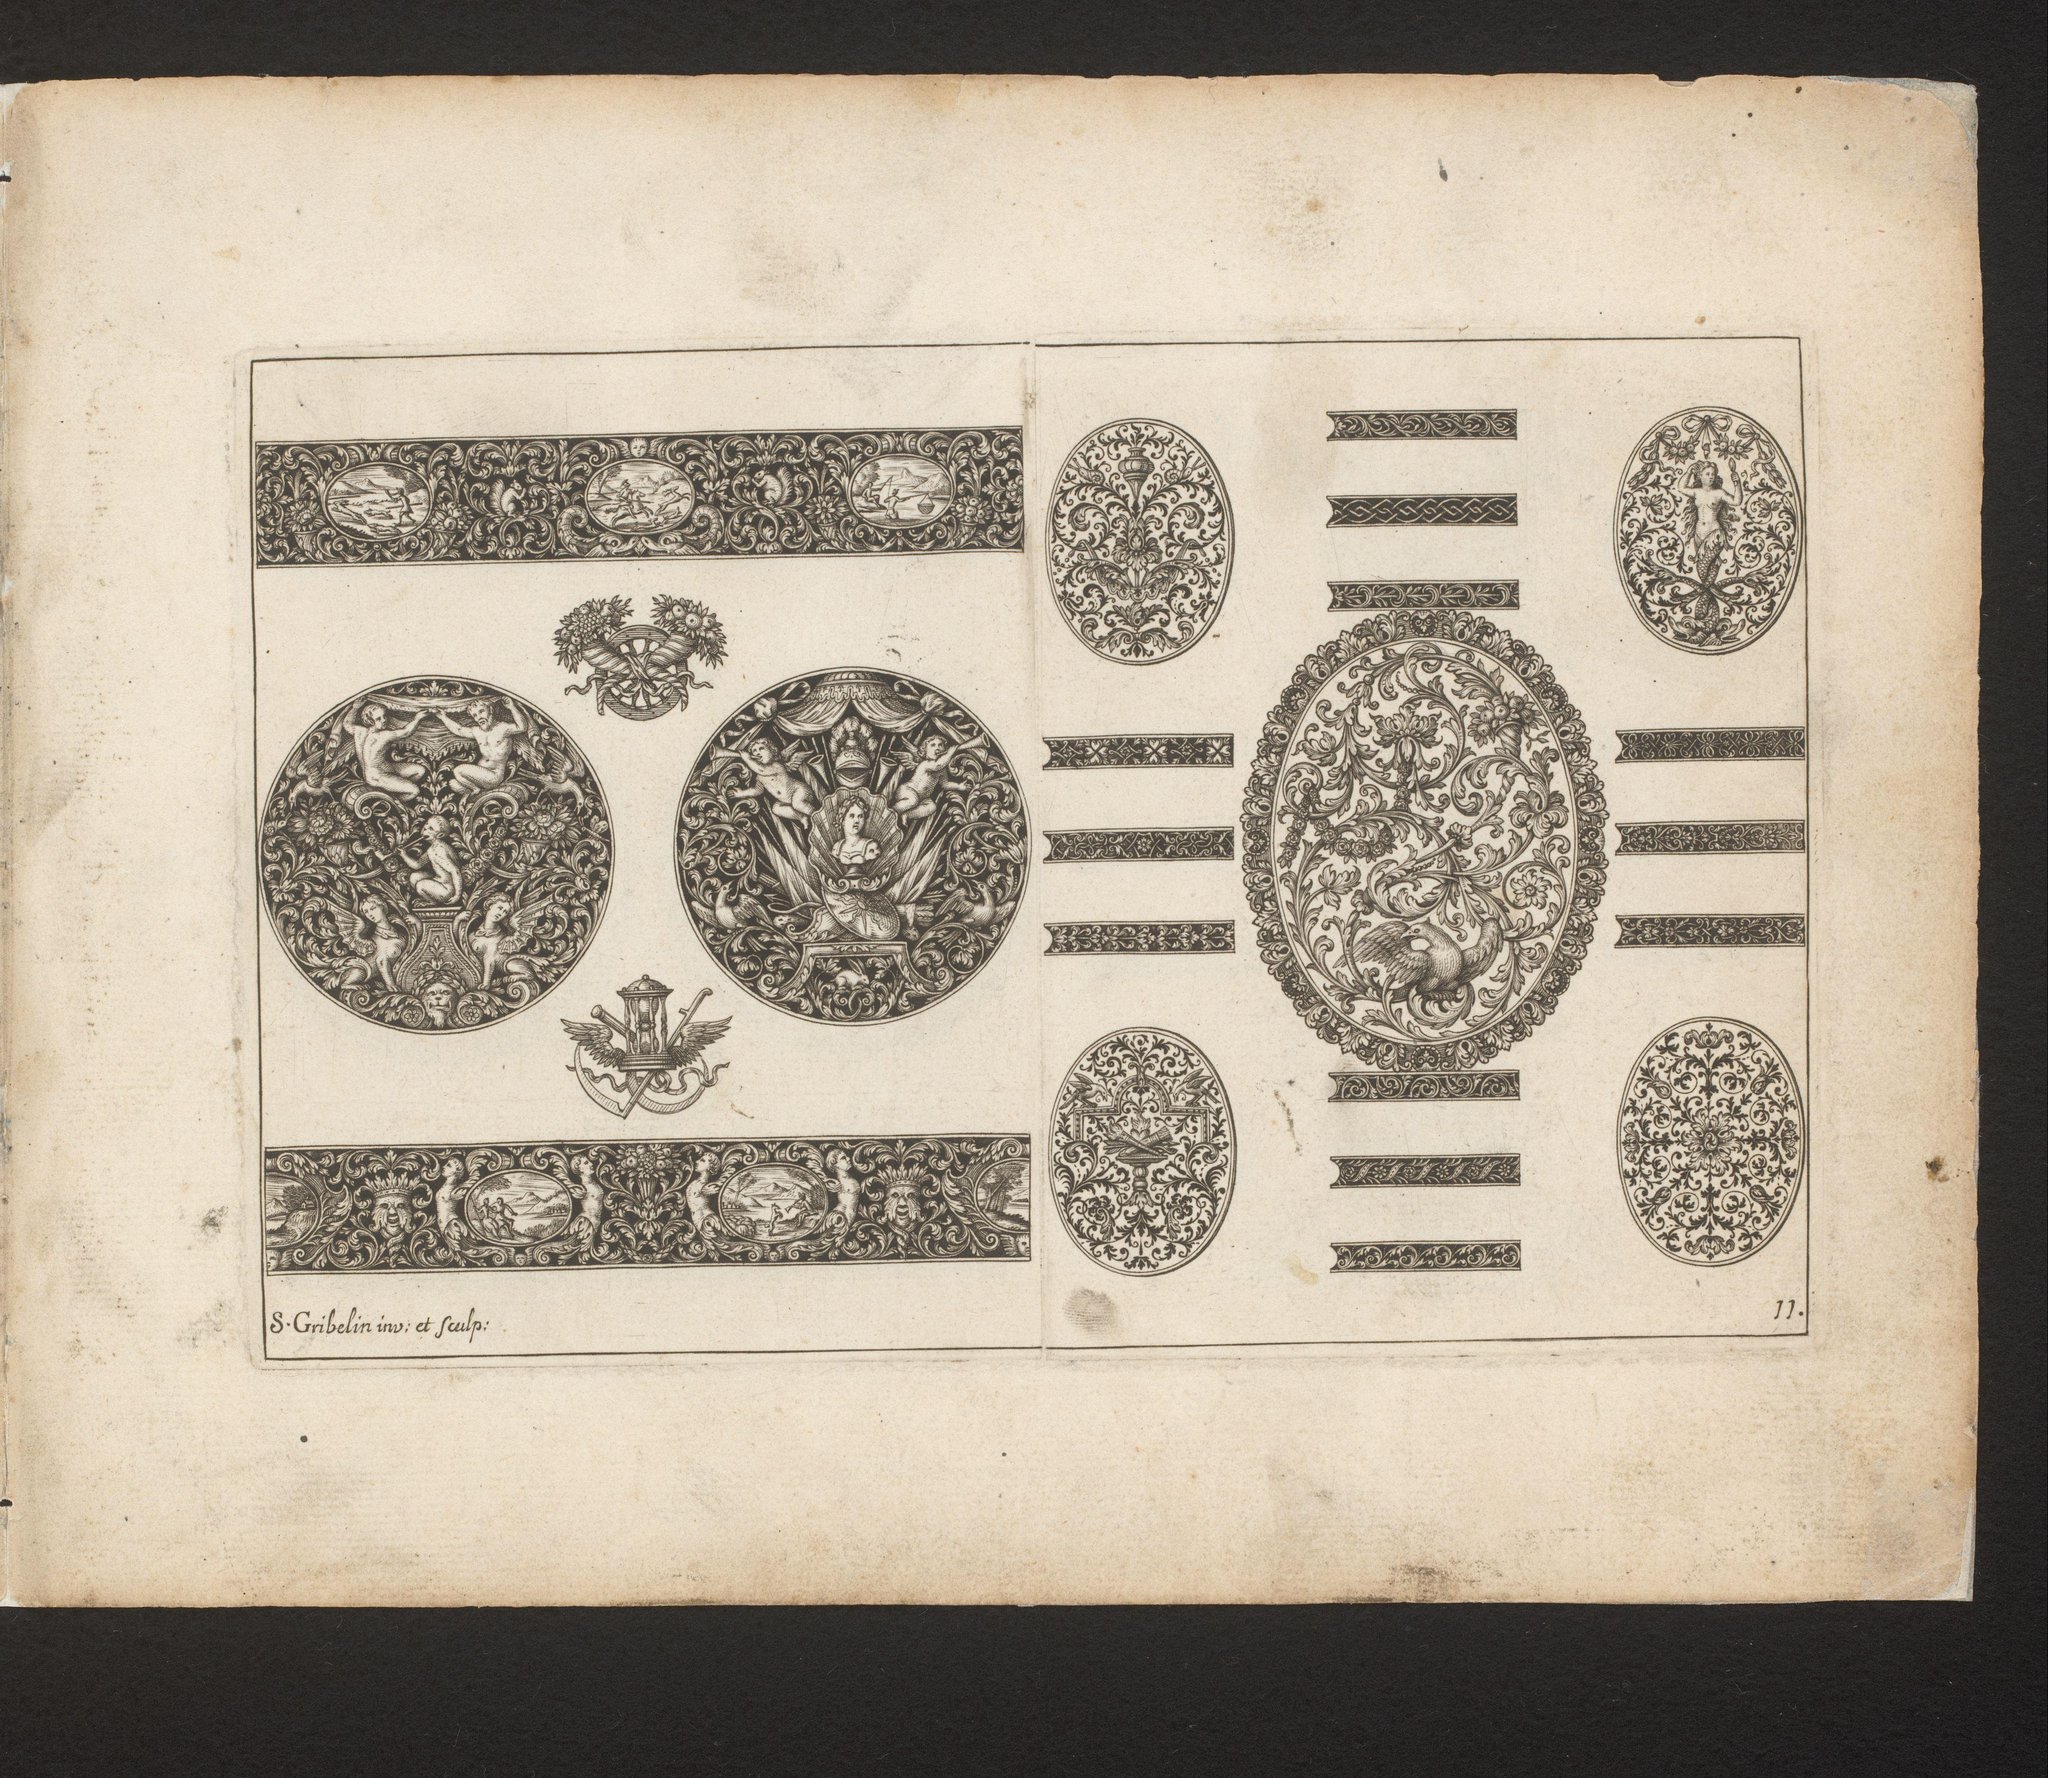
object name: ornament print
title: A Book of Ornaments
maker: simon gribelin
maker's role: print maker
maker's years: 1661-1733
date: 1704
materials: paper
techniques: engraving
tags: ornaments ~ art, cupids: 'amores', 'amoretti', 'putti', ornament derived from plant forms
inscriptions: collector's mark: Lugt 2760, collector's mark: Lugt 2228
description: De eerste versie van deze prentserie is uitgegeven in 1682 met de titel 'A Book of Severall Ornaments'.